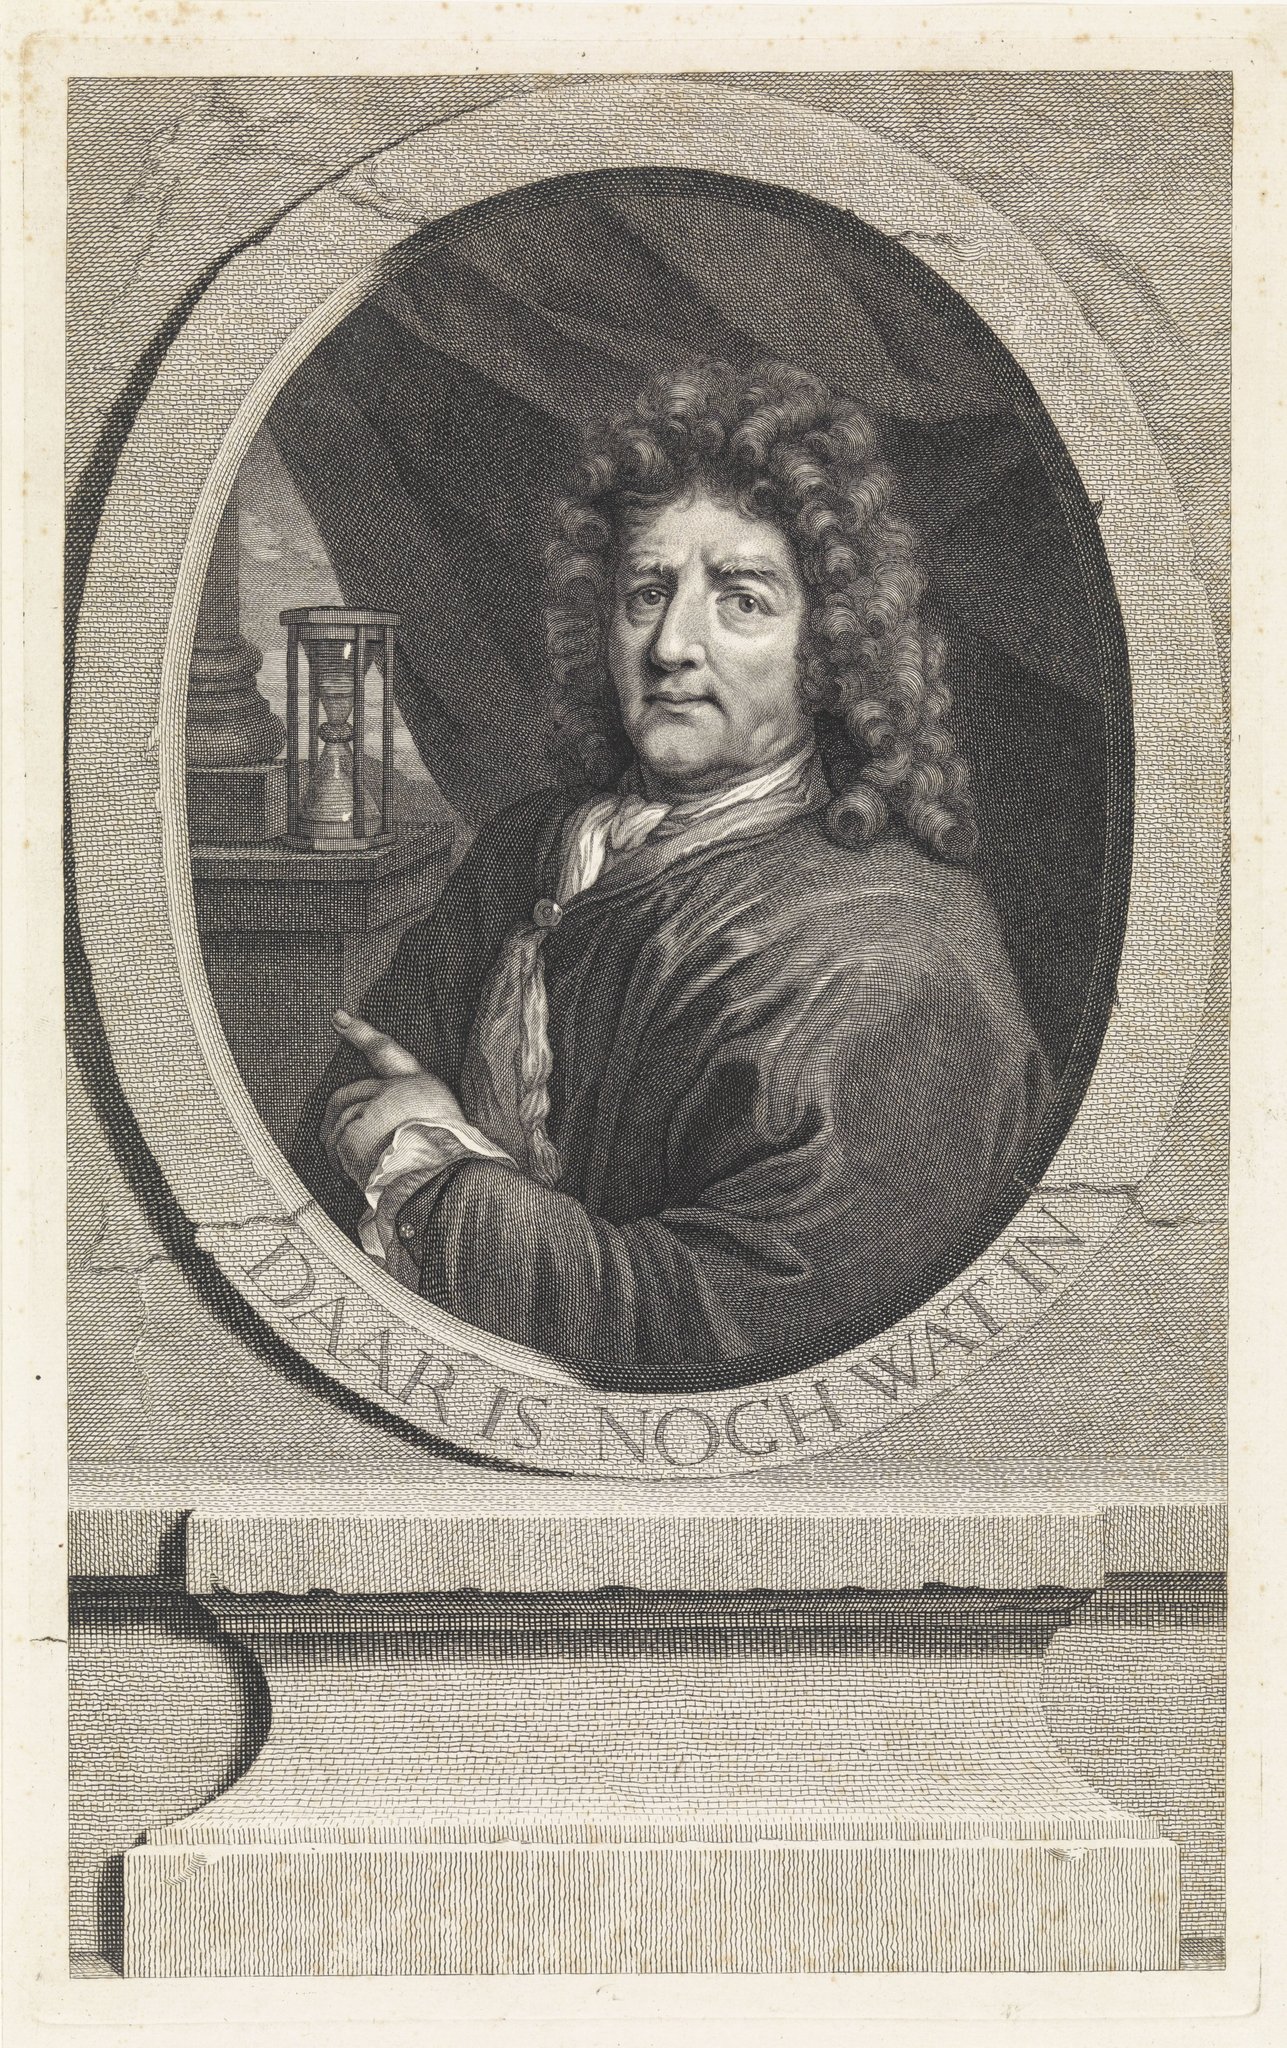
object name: print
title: Daar is noch wat in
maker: matthijs pool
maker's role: print maker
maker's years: 1676-1740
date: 1696-1727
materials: paper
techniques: engraving, etching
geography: amsterdam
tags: portrait, self-portrait of painter, hourglass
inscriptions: collector's mark: Lugt 2166, collector's mark: Lugt 2760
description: Portret van de schilder Barend Graat. Met zijn linkerhand wijst hij op een zandloper.